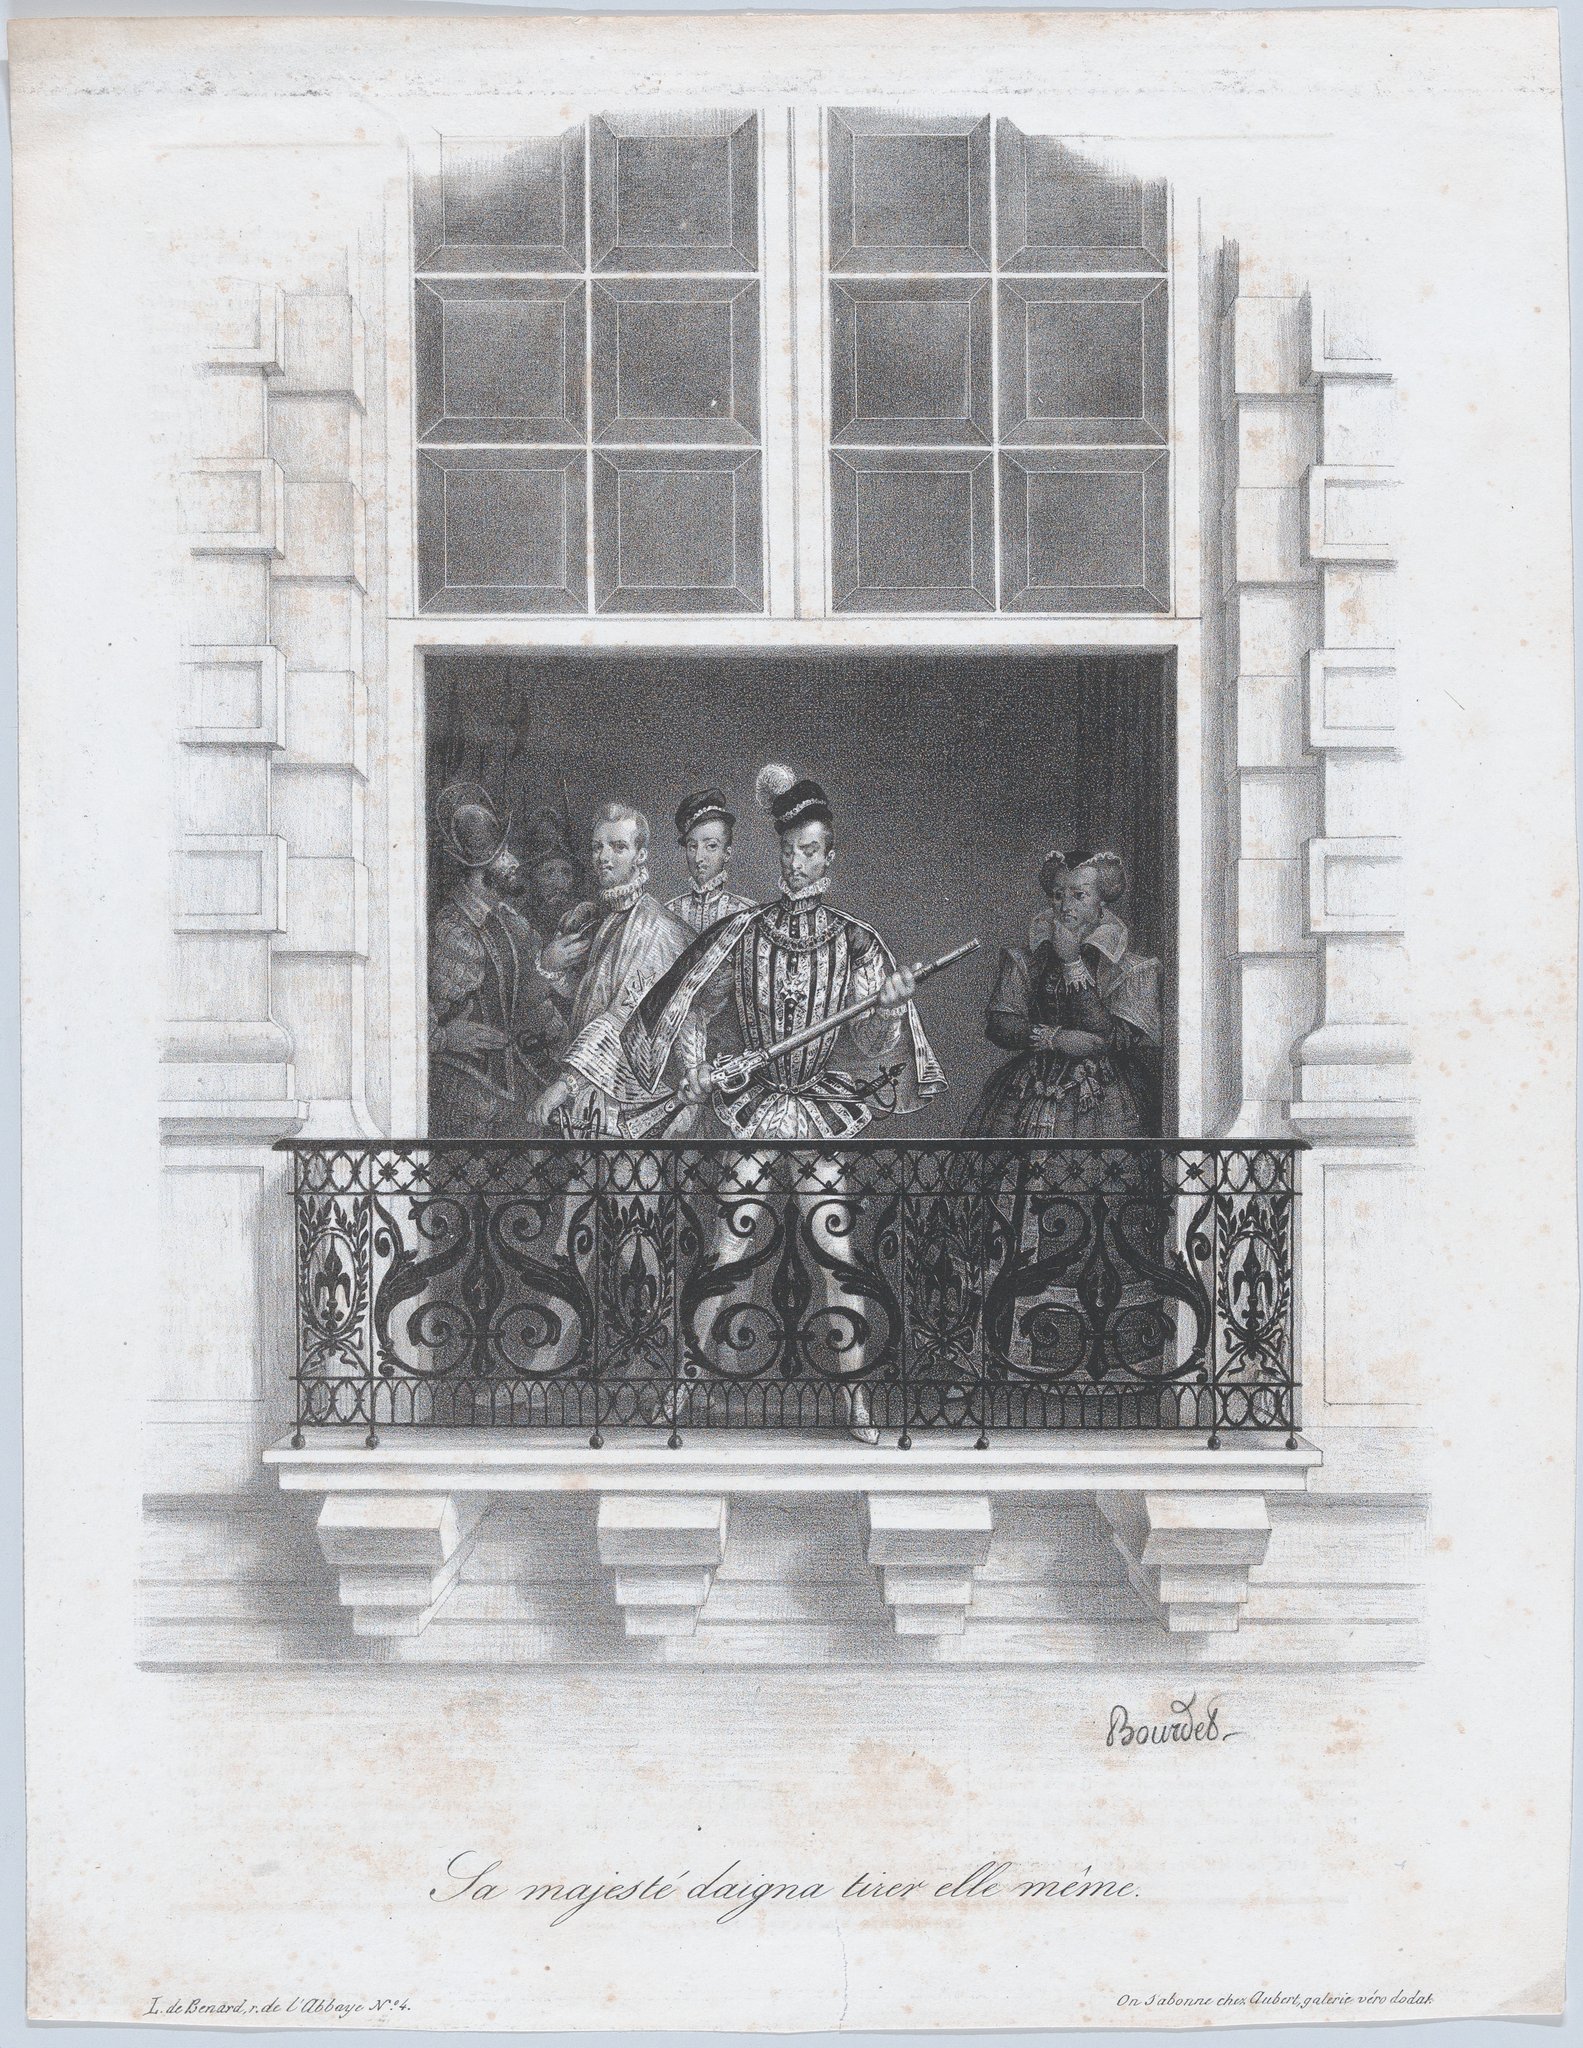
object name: print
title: Your Majesty Deigns To Kill Herself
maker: jules-joseph-guillaume bourdet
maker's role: artist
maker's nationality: french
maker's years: 1799-1869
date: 1849-1869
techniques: lithograph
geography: paris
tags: firearms,men,women